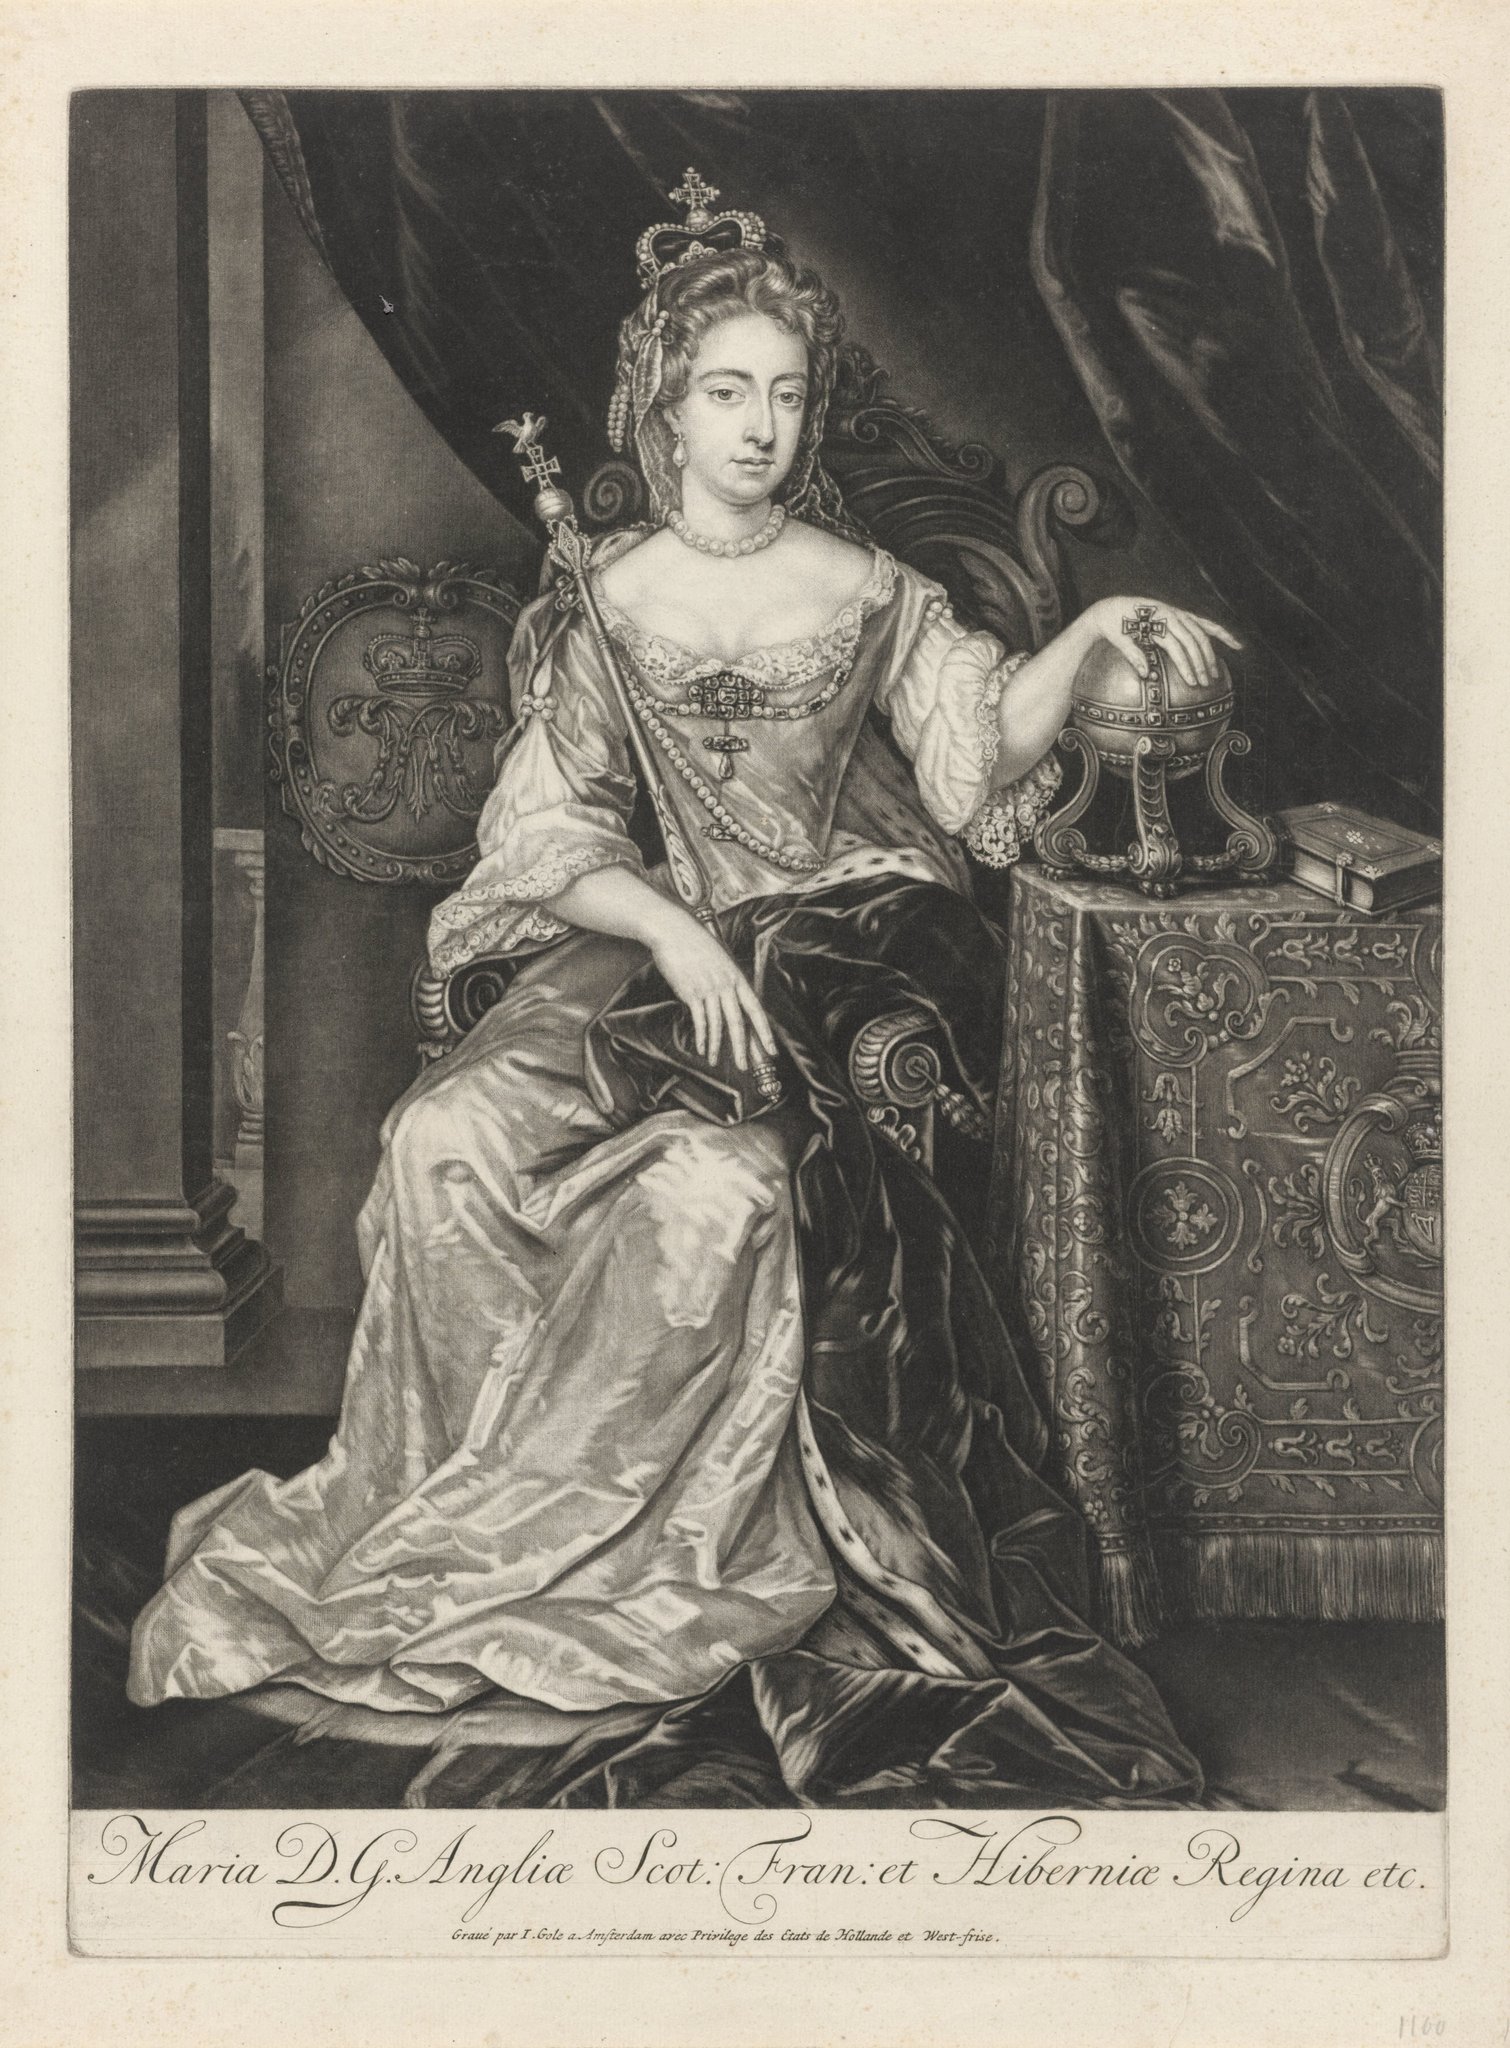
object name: print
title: Portret van Maria II Stuart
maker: jacob gole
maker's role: print maker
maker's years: 1660-1724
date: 1688-1724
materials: paper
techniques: mezzotint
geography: amsterdam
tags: london, maria ii stuart (koningin van engeland, schotland en ierland)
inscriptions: collector's mark: Lugt 2228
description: Portret van Maria II met een kroon. In haar rechterhand een scepter. Haar linkerhand op de rijkspappel. In de ondermarge haar naam en titels.